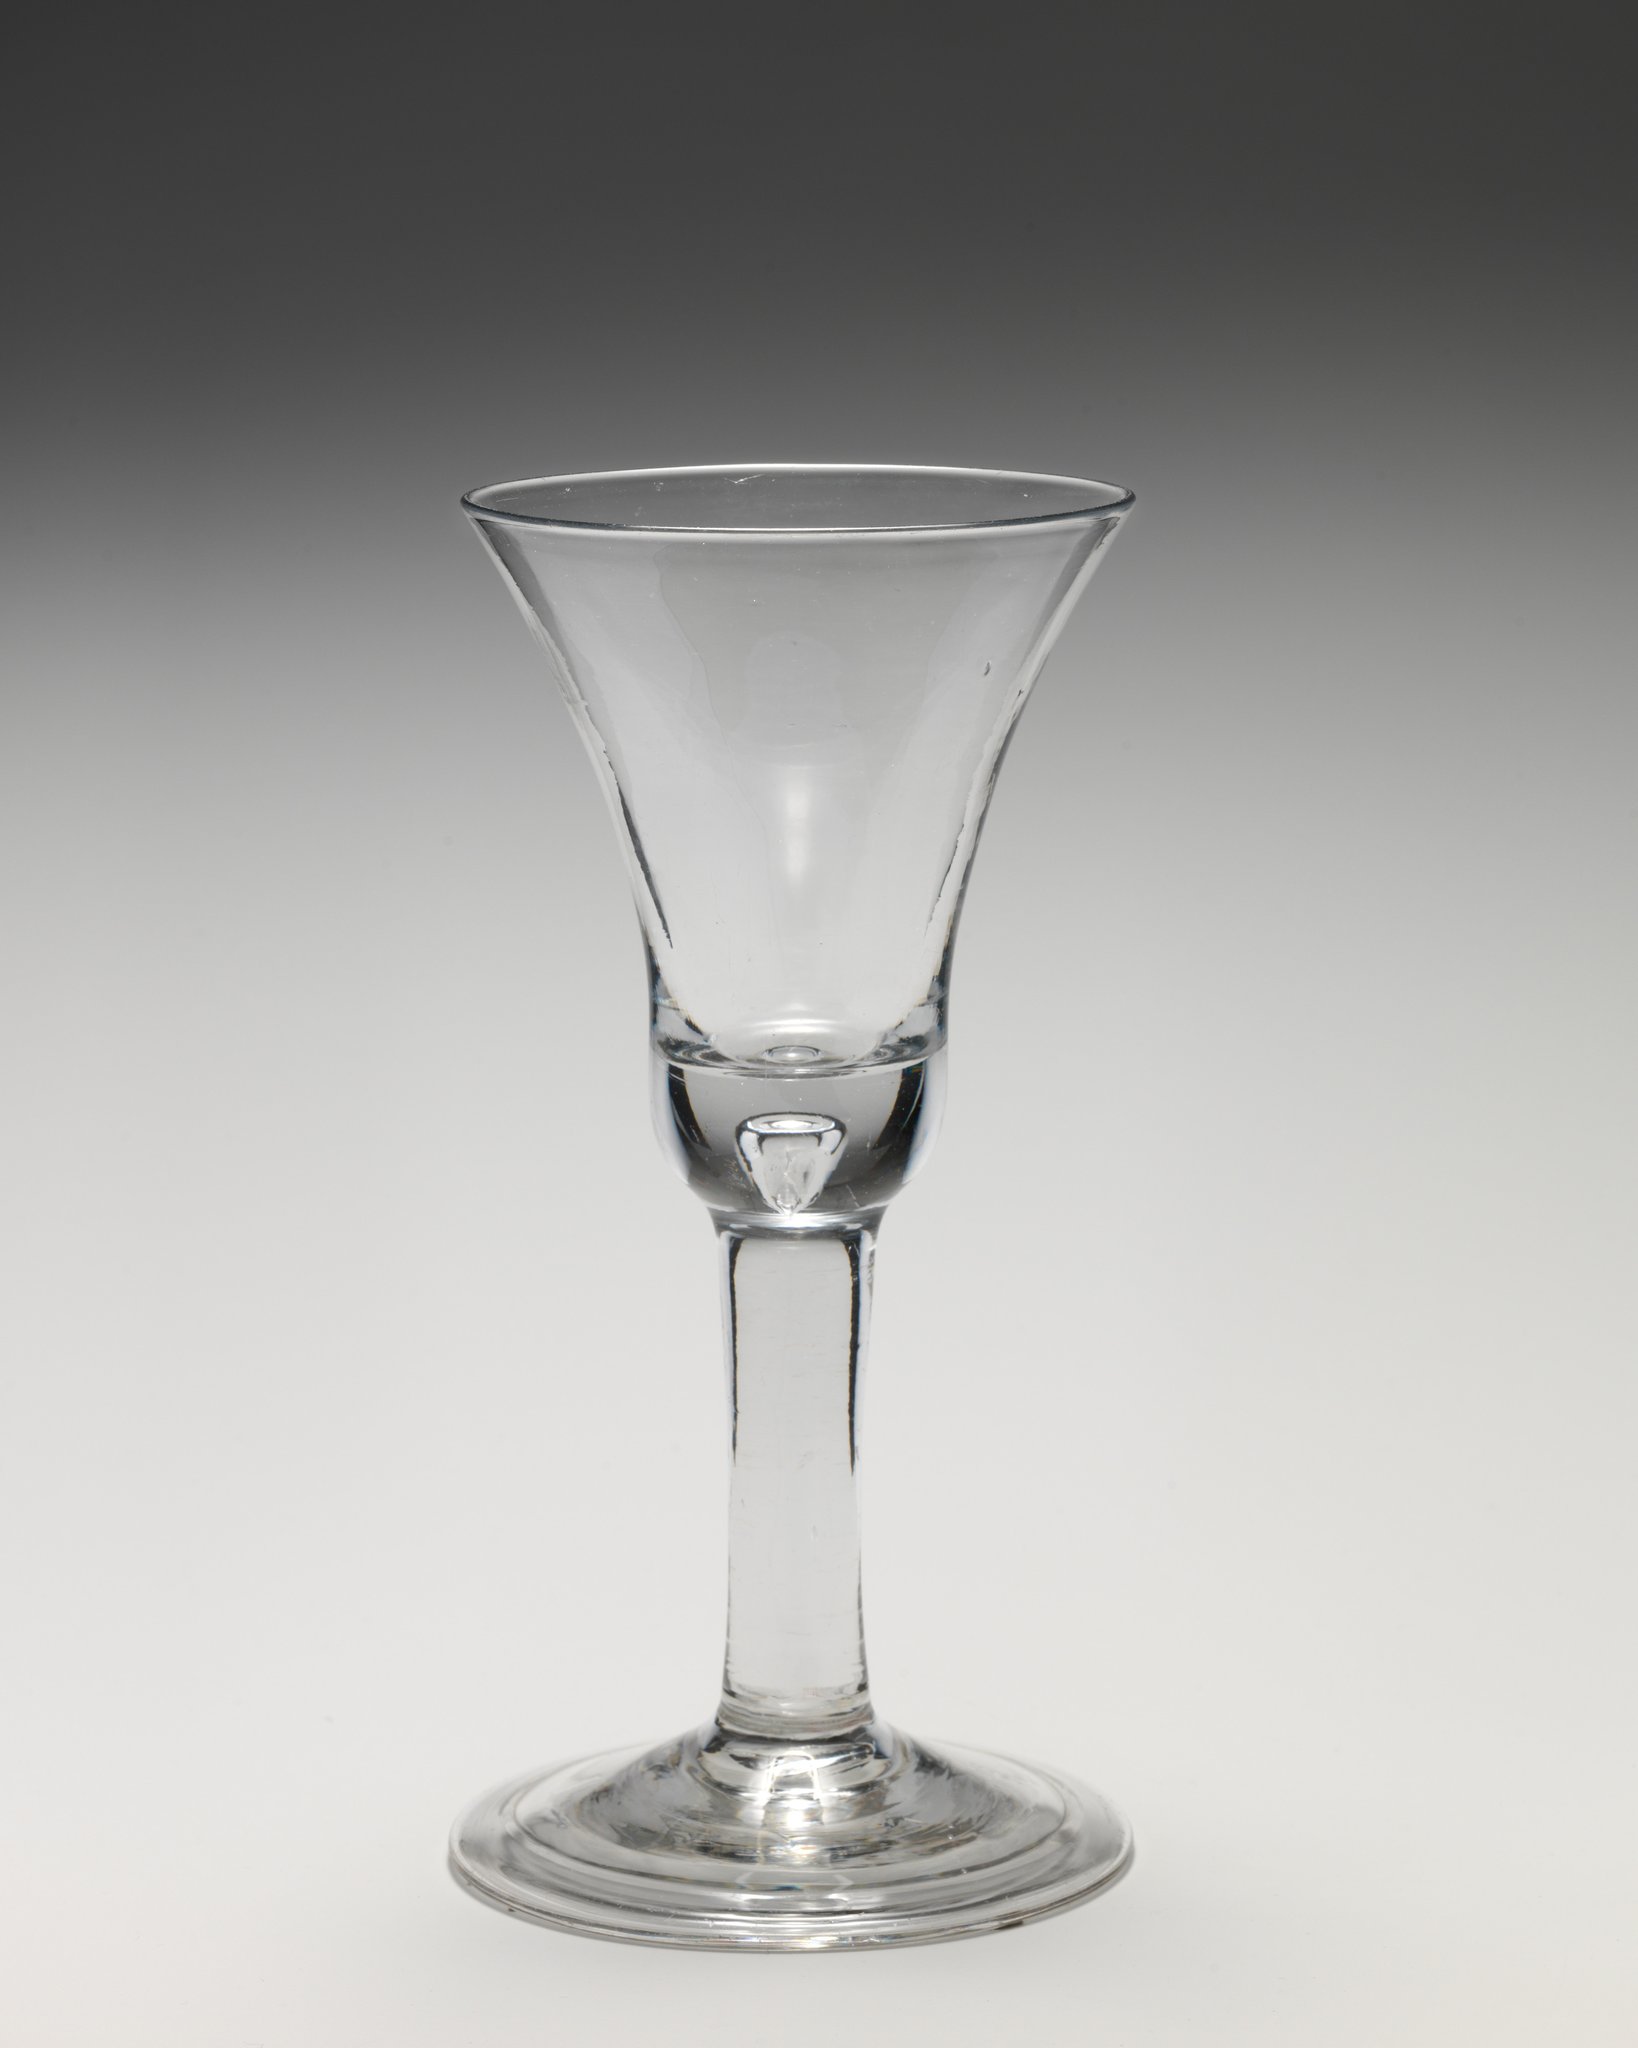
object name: beer or ale glass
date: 1701-1750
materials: glass